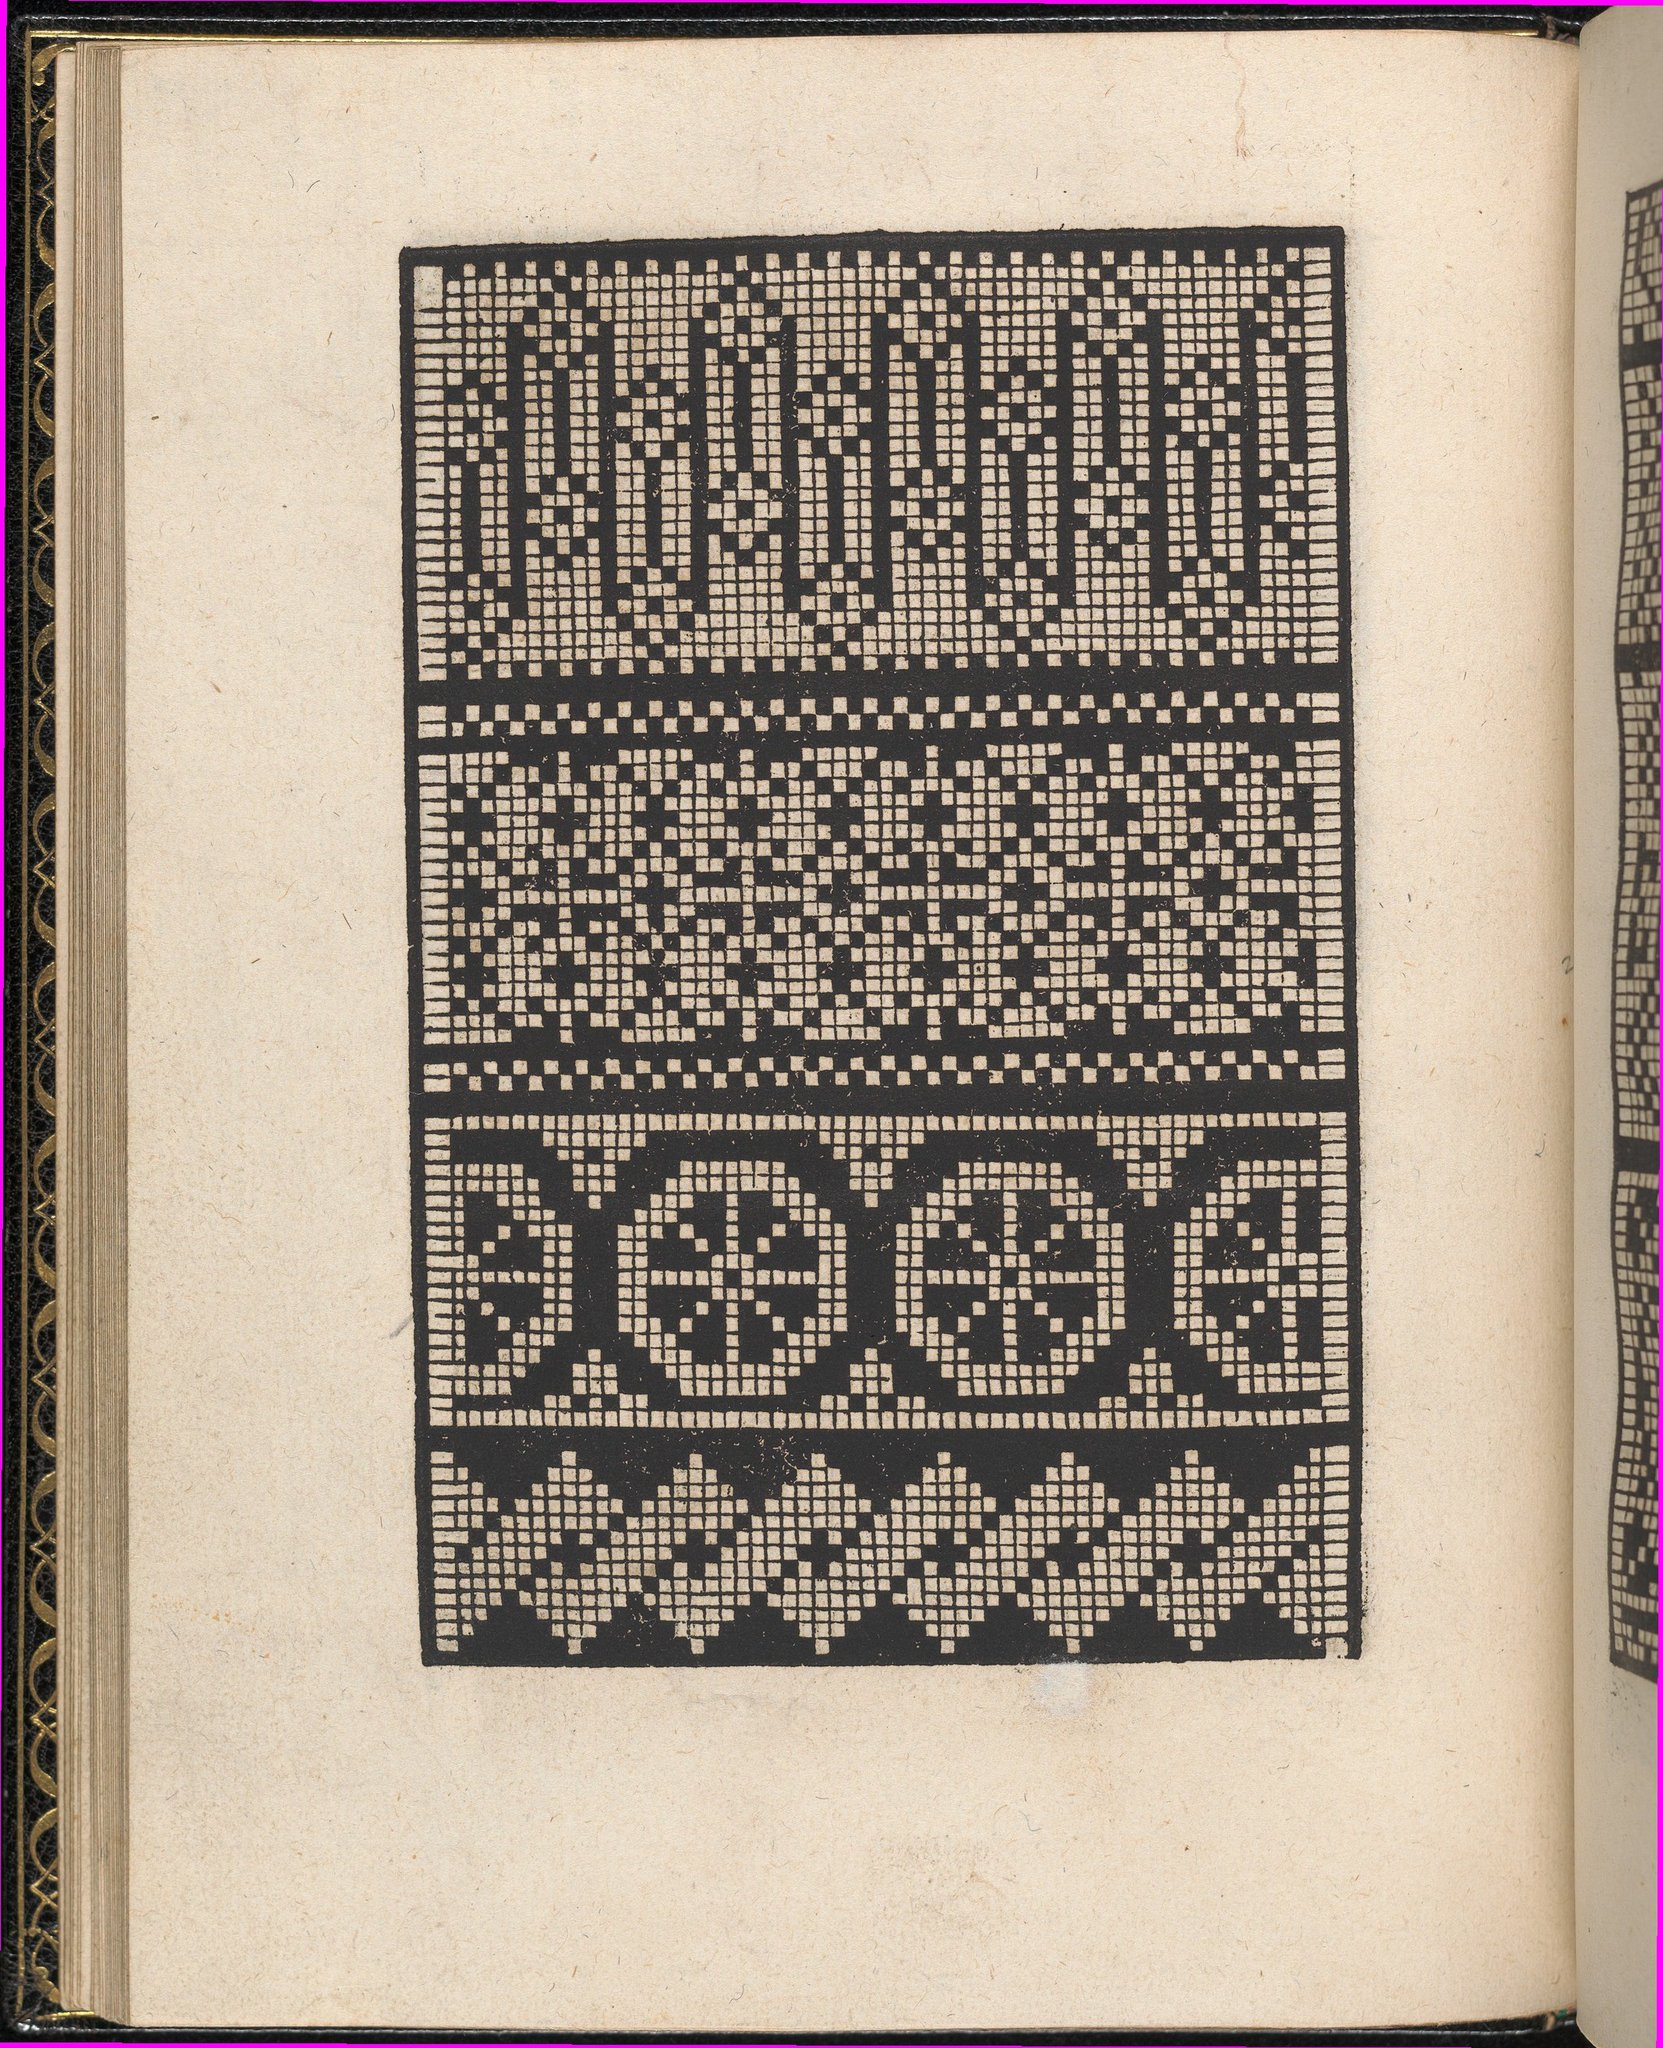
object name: book print ornament architecture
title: Page from Ein new kunstlich Modelbuch...(Page 22v)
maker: peter quentel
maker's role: publisher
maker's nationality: german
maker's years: 1500-1550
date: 1544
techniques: woodcut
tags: flowers